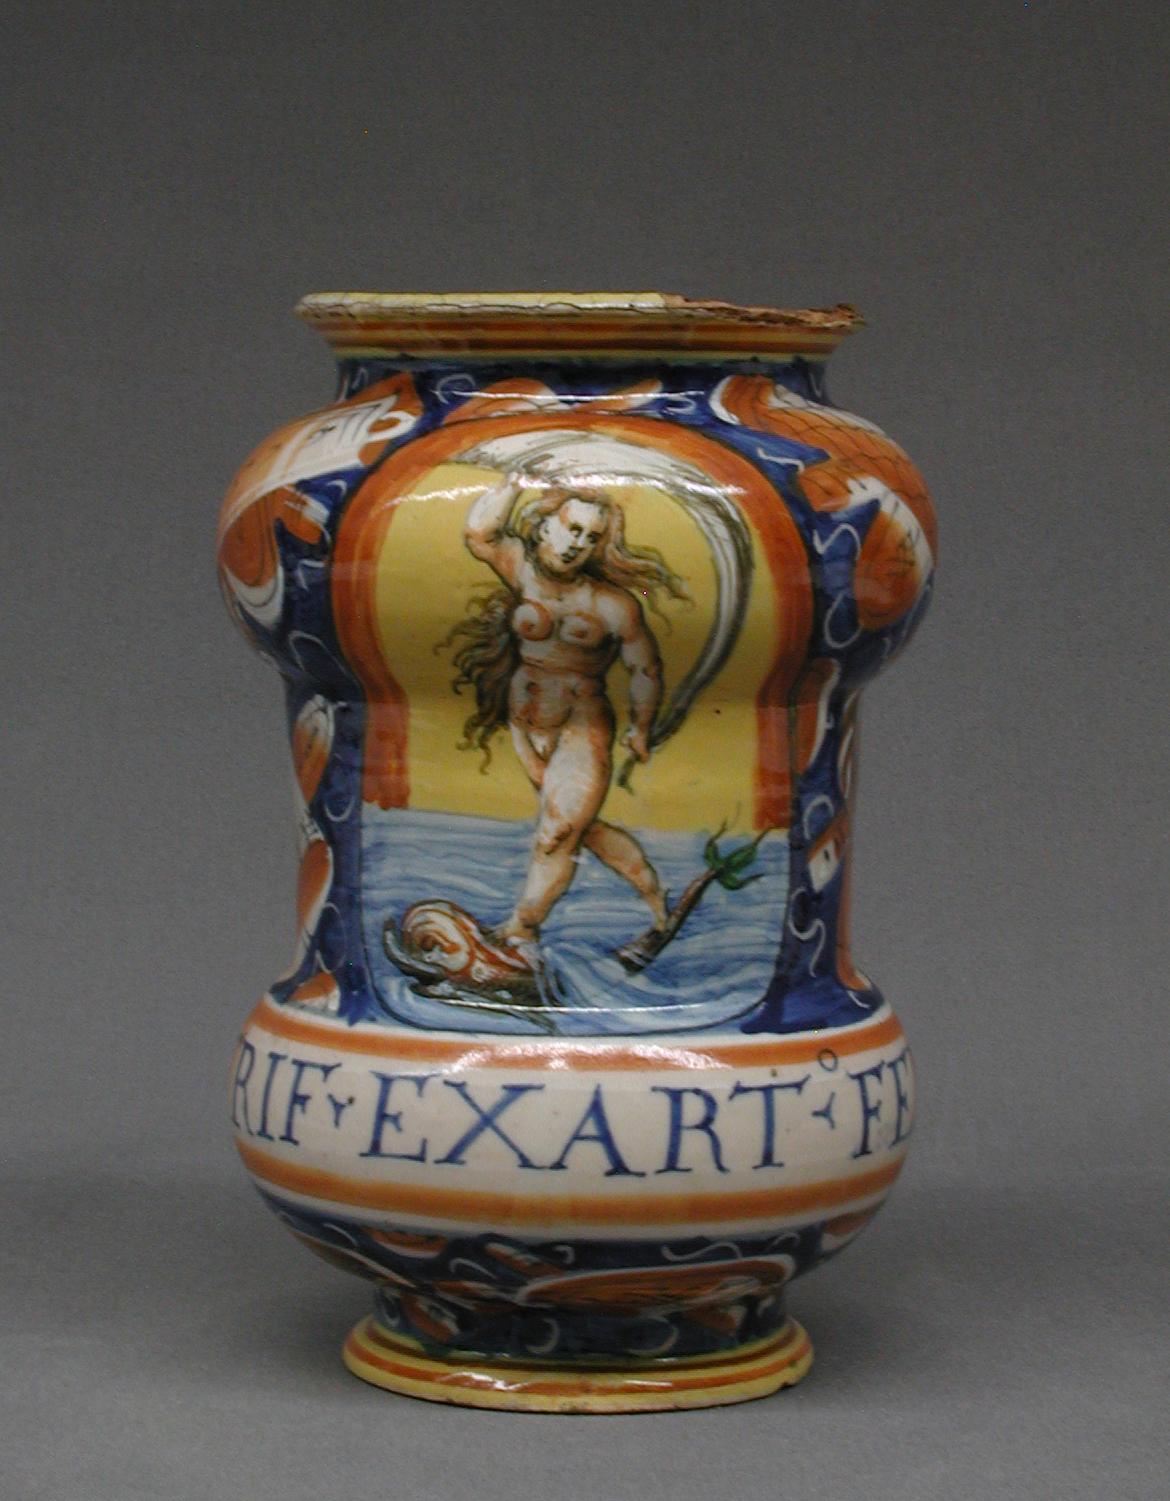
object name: pharmacy jar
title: Pharmacy jar (albarello) (one of a pair)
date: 1579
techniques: maiolica, glazing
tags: dolphins,goddess